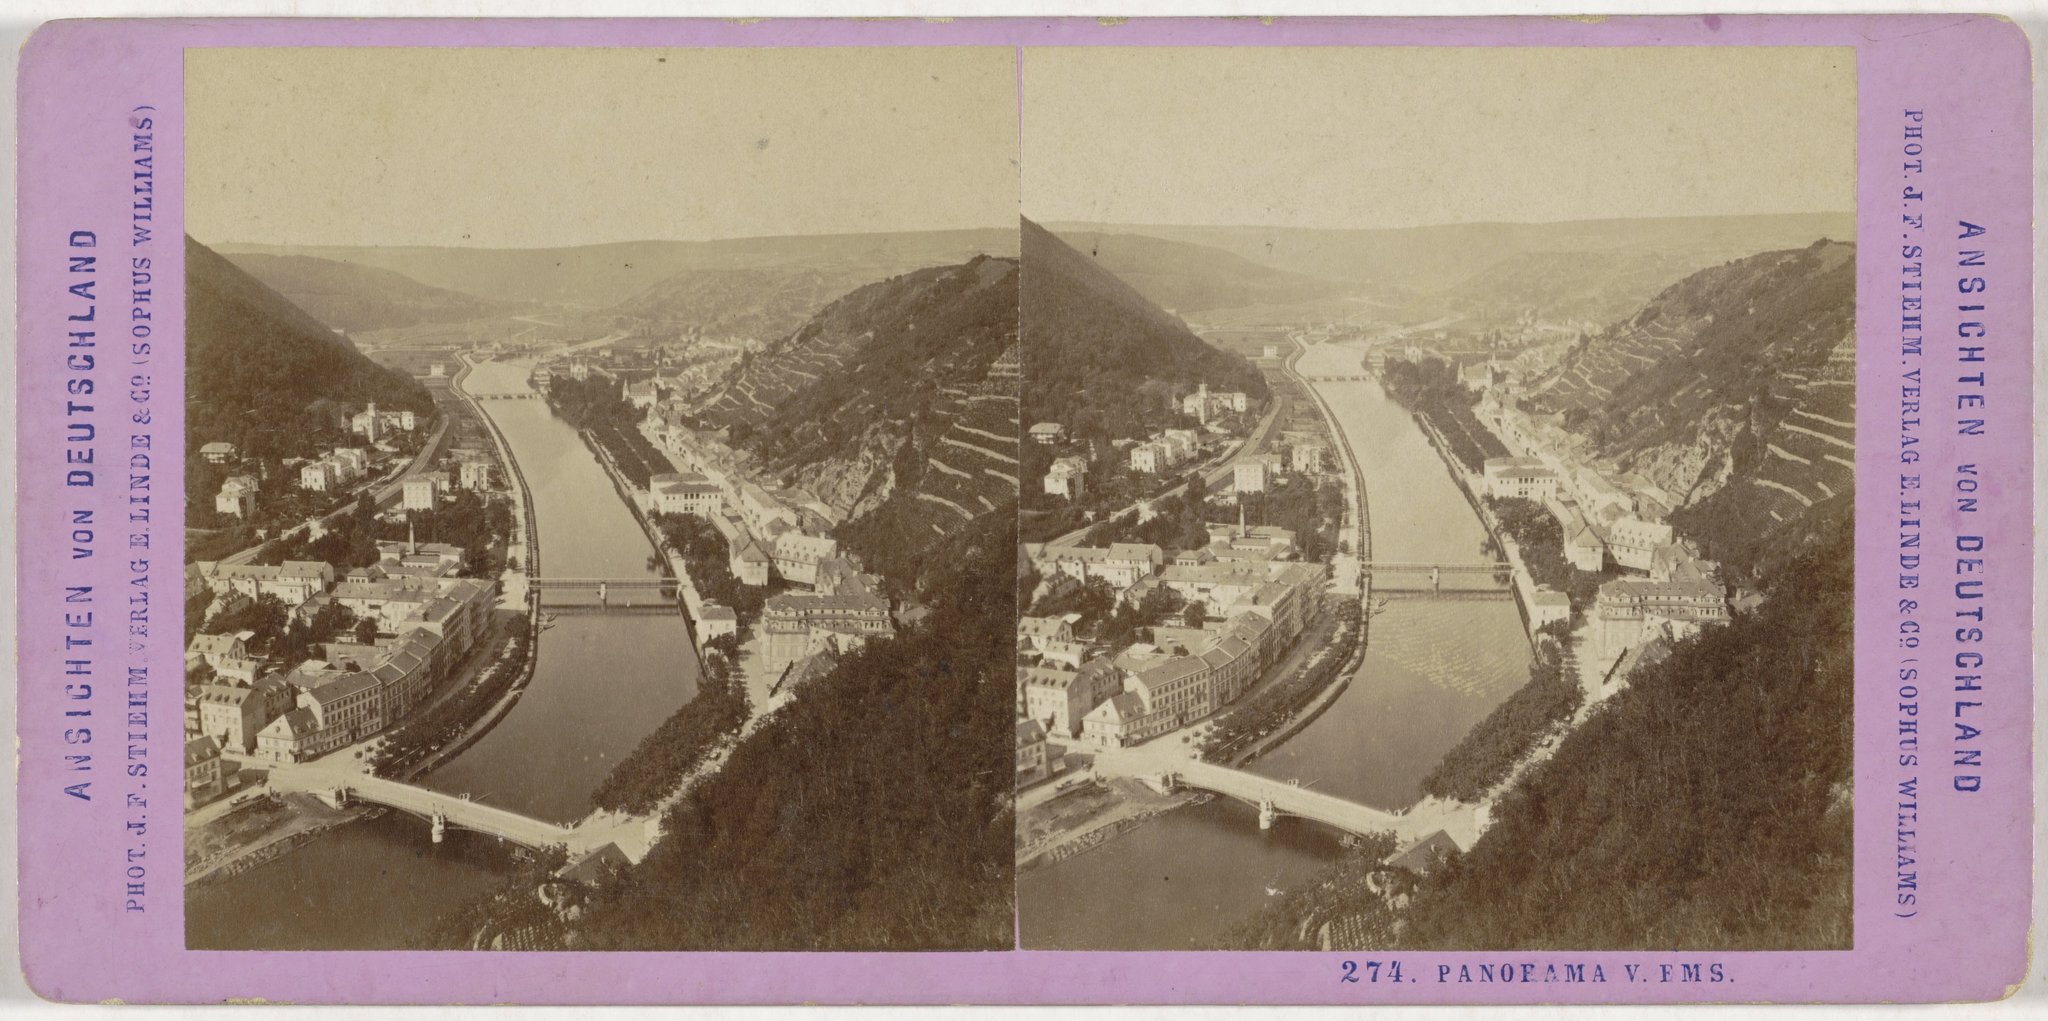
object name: stereograph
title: Ansichten von Deutschland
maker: johann friedrich stiehm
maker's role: fotograaf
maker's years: 1826-1902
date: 1869-1872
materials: cardboard, paper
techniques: albumen print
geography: berlin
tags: river, village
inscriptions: inscription: ‘50’, inscription: ‘R. ka. W.’, inscription: ‘N.W.’, number: ‘274.’